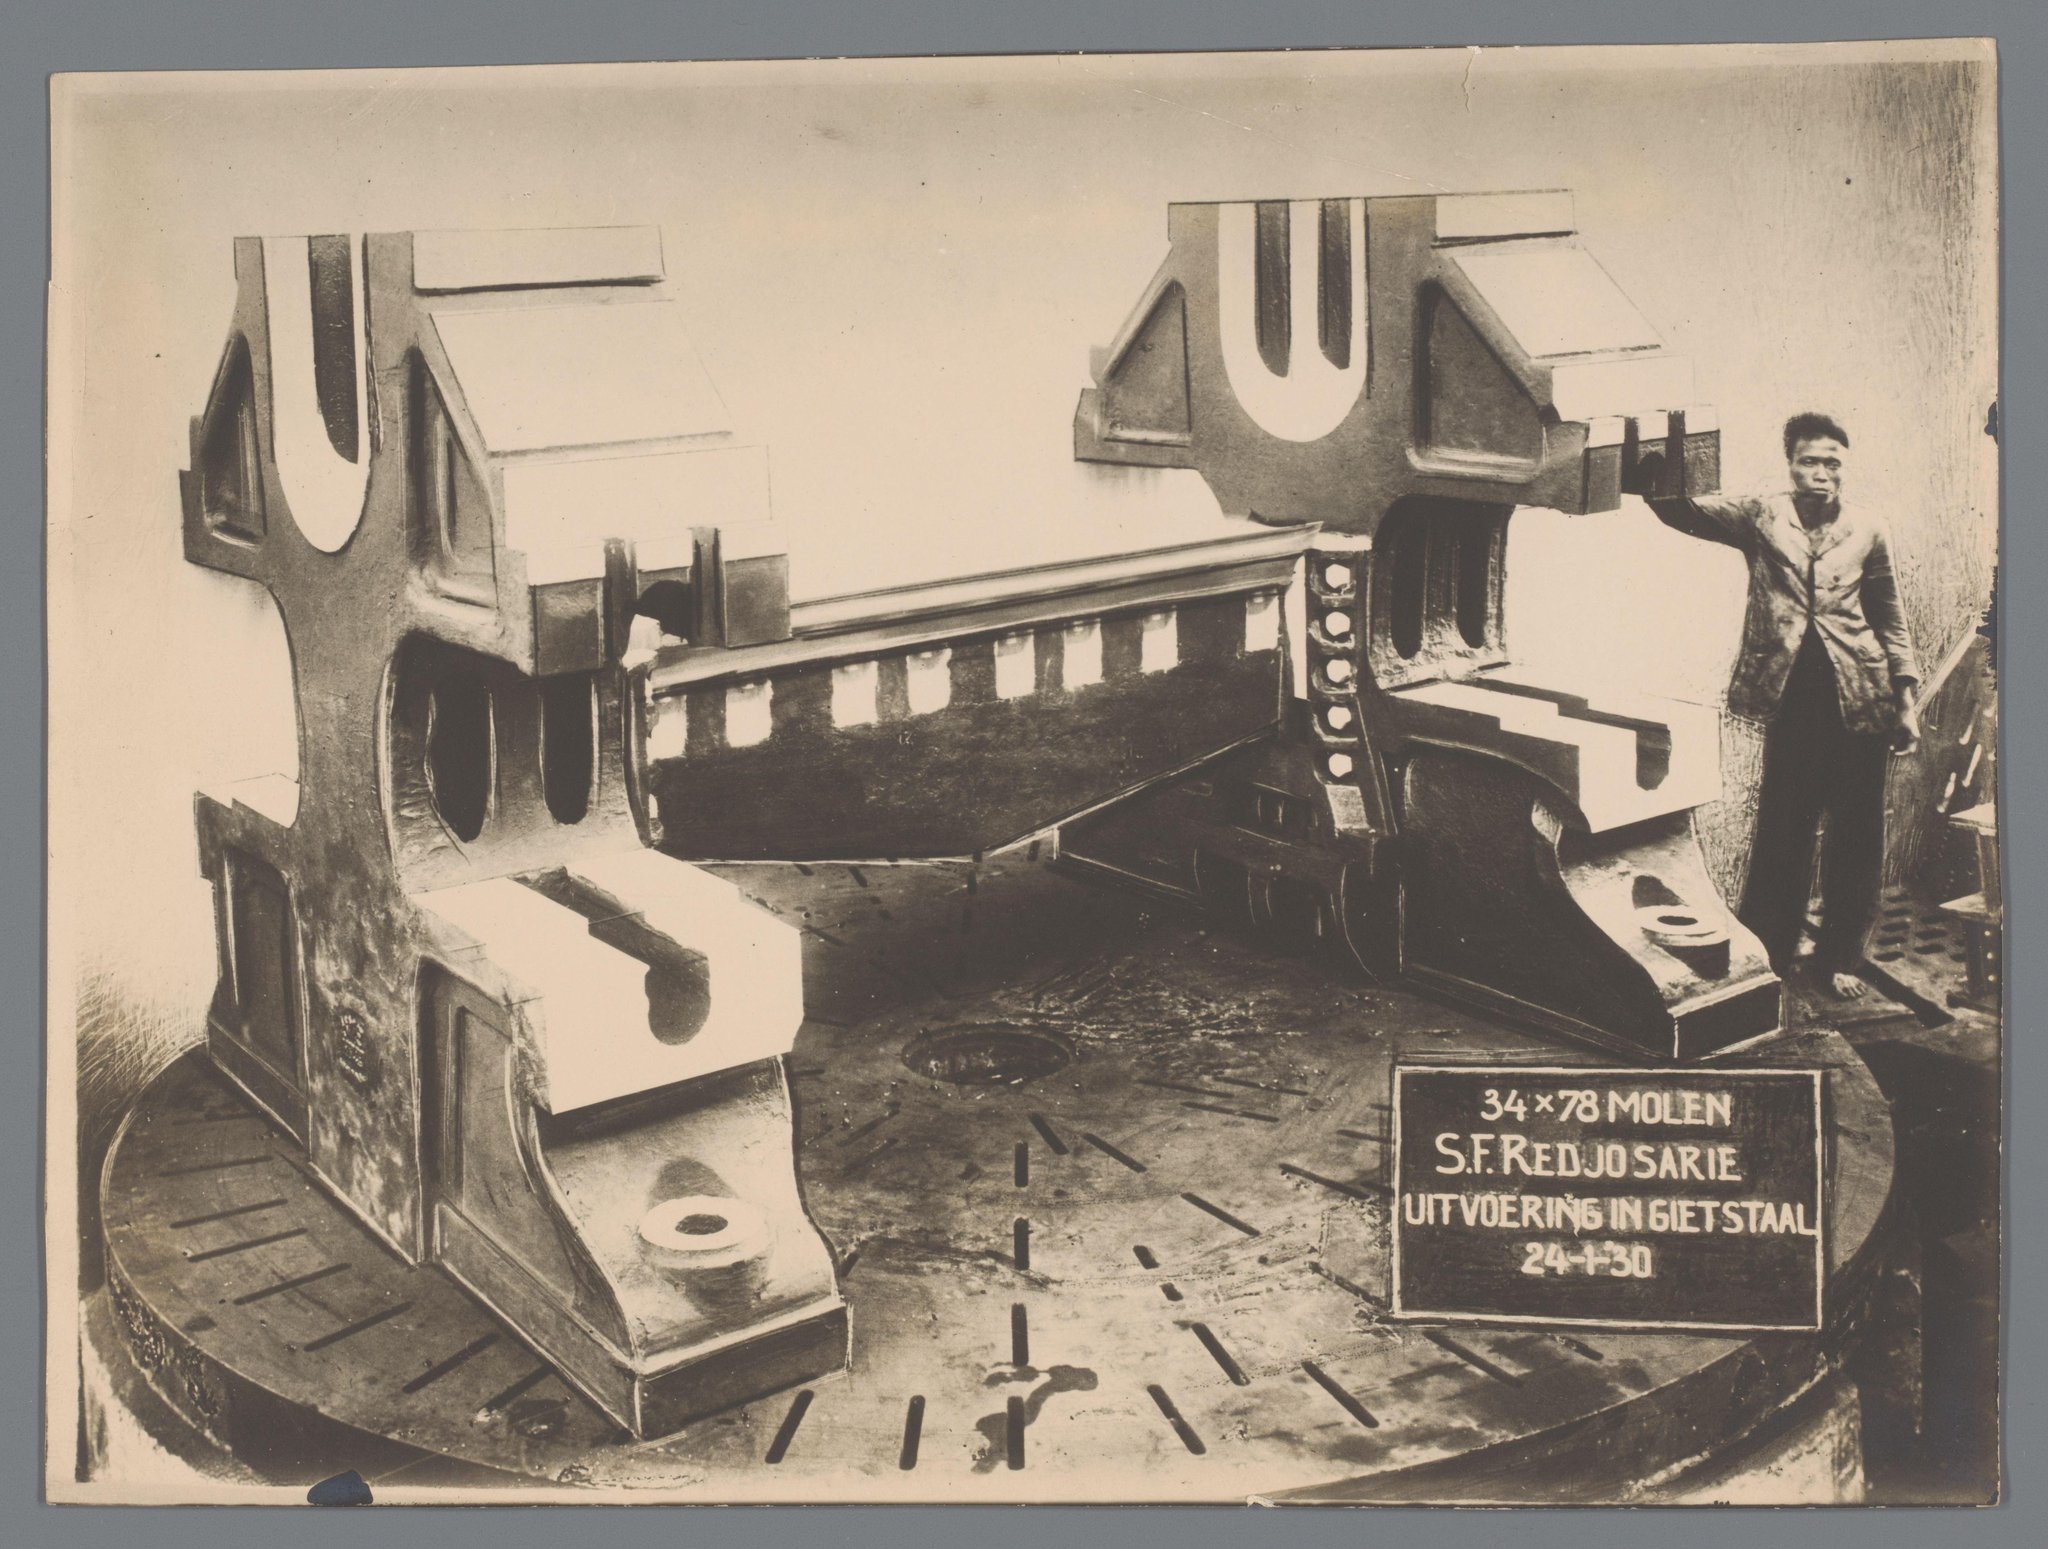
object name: photograph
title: Molenstandaard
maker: Anonymous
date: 1930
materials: photographic support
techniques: gelatin silver print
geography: surabaya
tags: colonial system, machines; parts of machines; tools and appliances, factory-interior, machine shop (+ labourers ~ crafts, industries, agriculture), (non-fruit) products of plants or trees: sugarcane, java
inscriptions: date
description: Een molenstandaard met ampasstooterbalk en plaat, vervaardigd in 1930 en bestemd voor suikerfabriek Redjosarie bij Madioen op Oost-Java. Onderdeel van de multomap met foto's van machines van de N.V. Machinefabriek Braat te Soerabaja bestemd voor de Nederlandse suikerindustrie op Java, uit de periode 1917-1938.